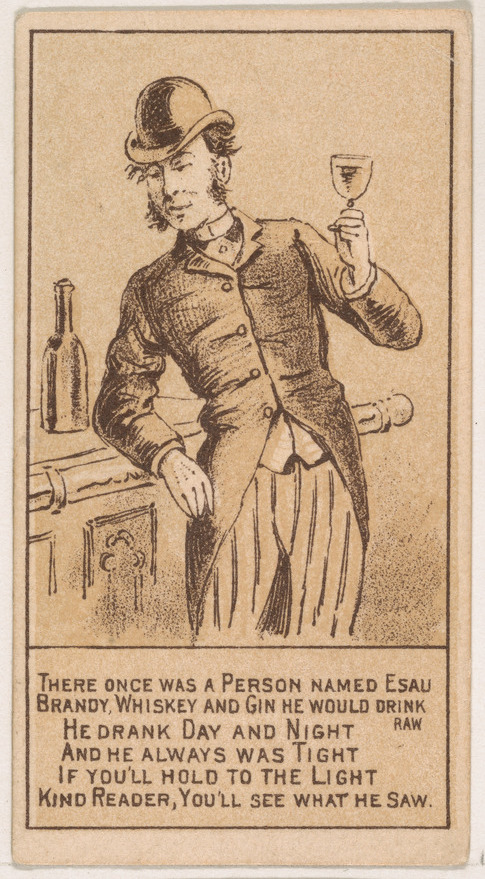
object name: print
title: There Once Was a Person Named Esau..., from the Magic Changing Cards series (N223) issued by Kinney Tobacco Company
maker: kinney brothers tobacco company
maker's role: publisher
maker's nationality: american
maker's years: 1869-2011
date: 1889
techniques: color lithograph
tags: men,drinking